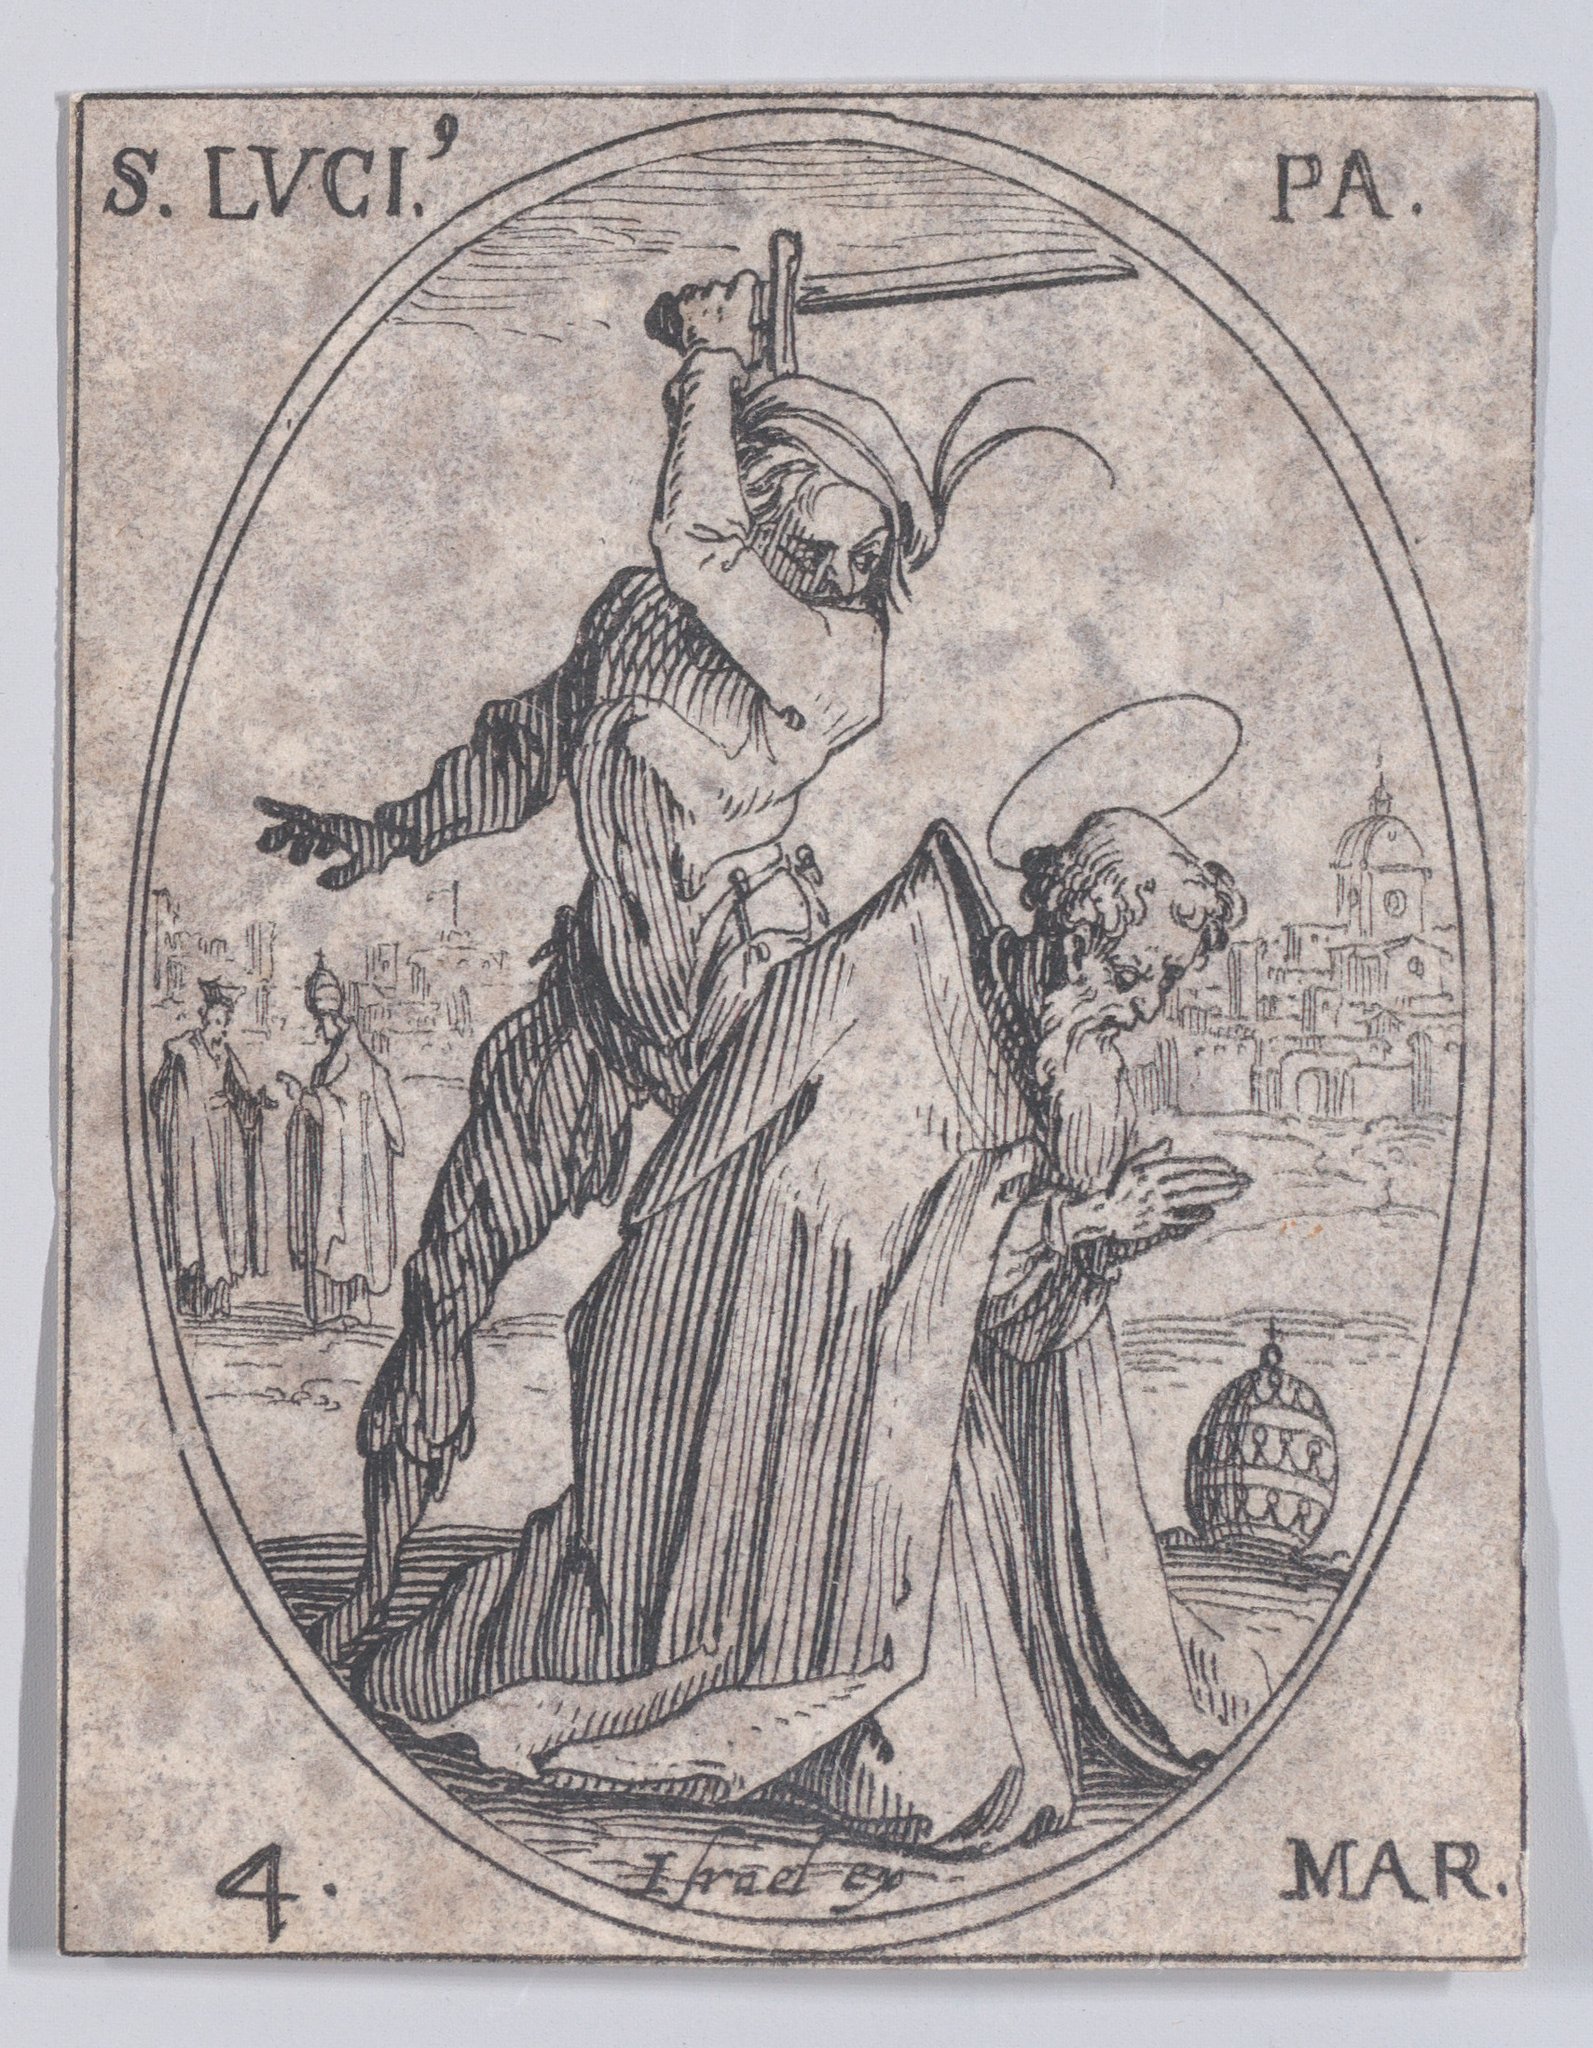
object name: print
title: S. Lucius, pape (St. Lucius, Pope), March 4th, from "Les Images De Tous Les Saincts et Saintes de L'Année" (Images of All of the Saints and Religious Events of the Year)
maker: jacques callot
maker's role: artist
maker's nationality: french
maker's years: 1592-1635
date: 1636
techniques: etching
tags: men,saints